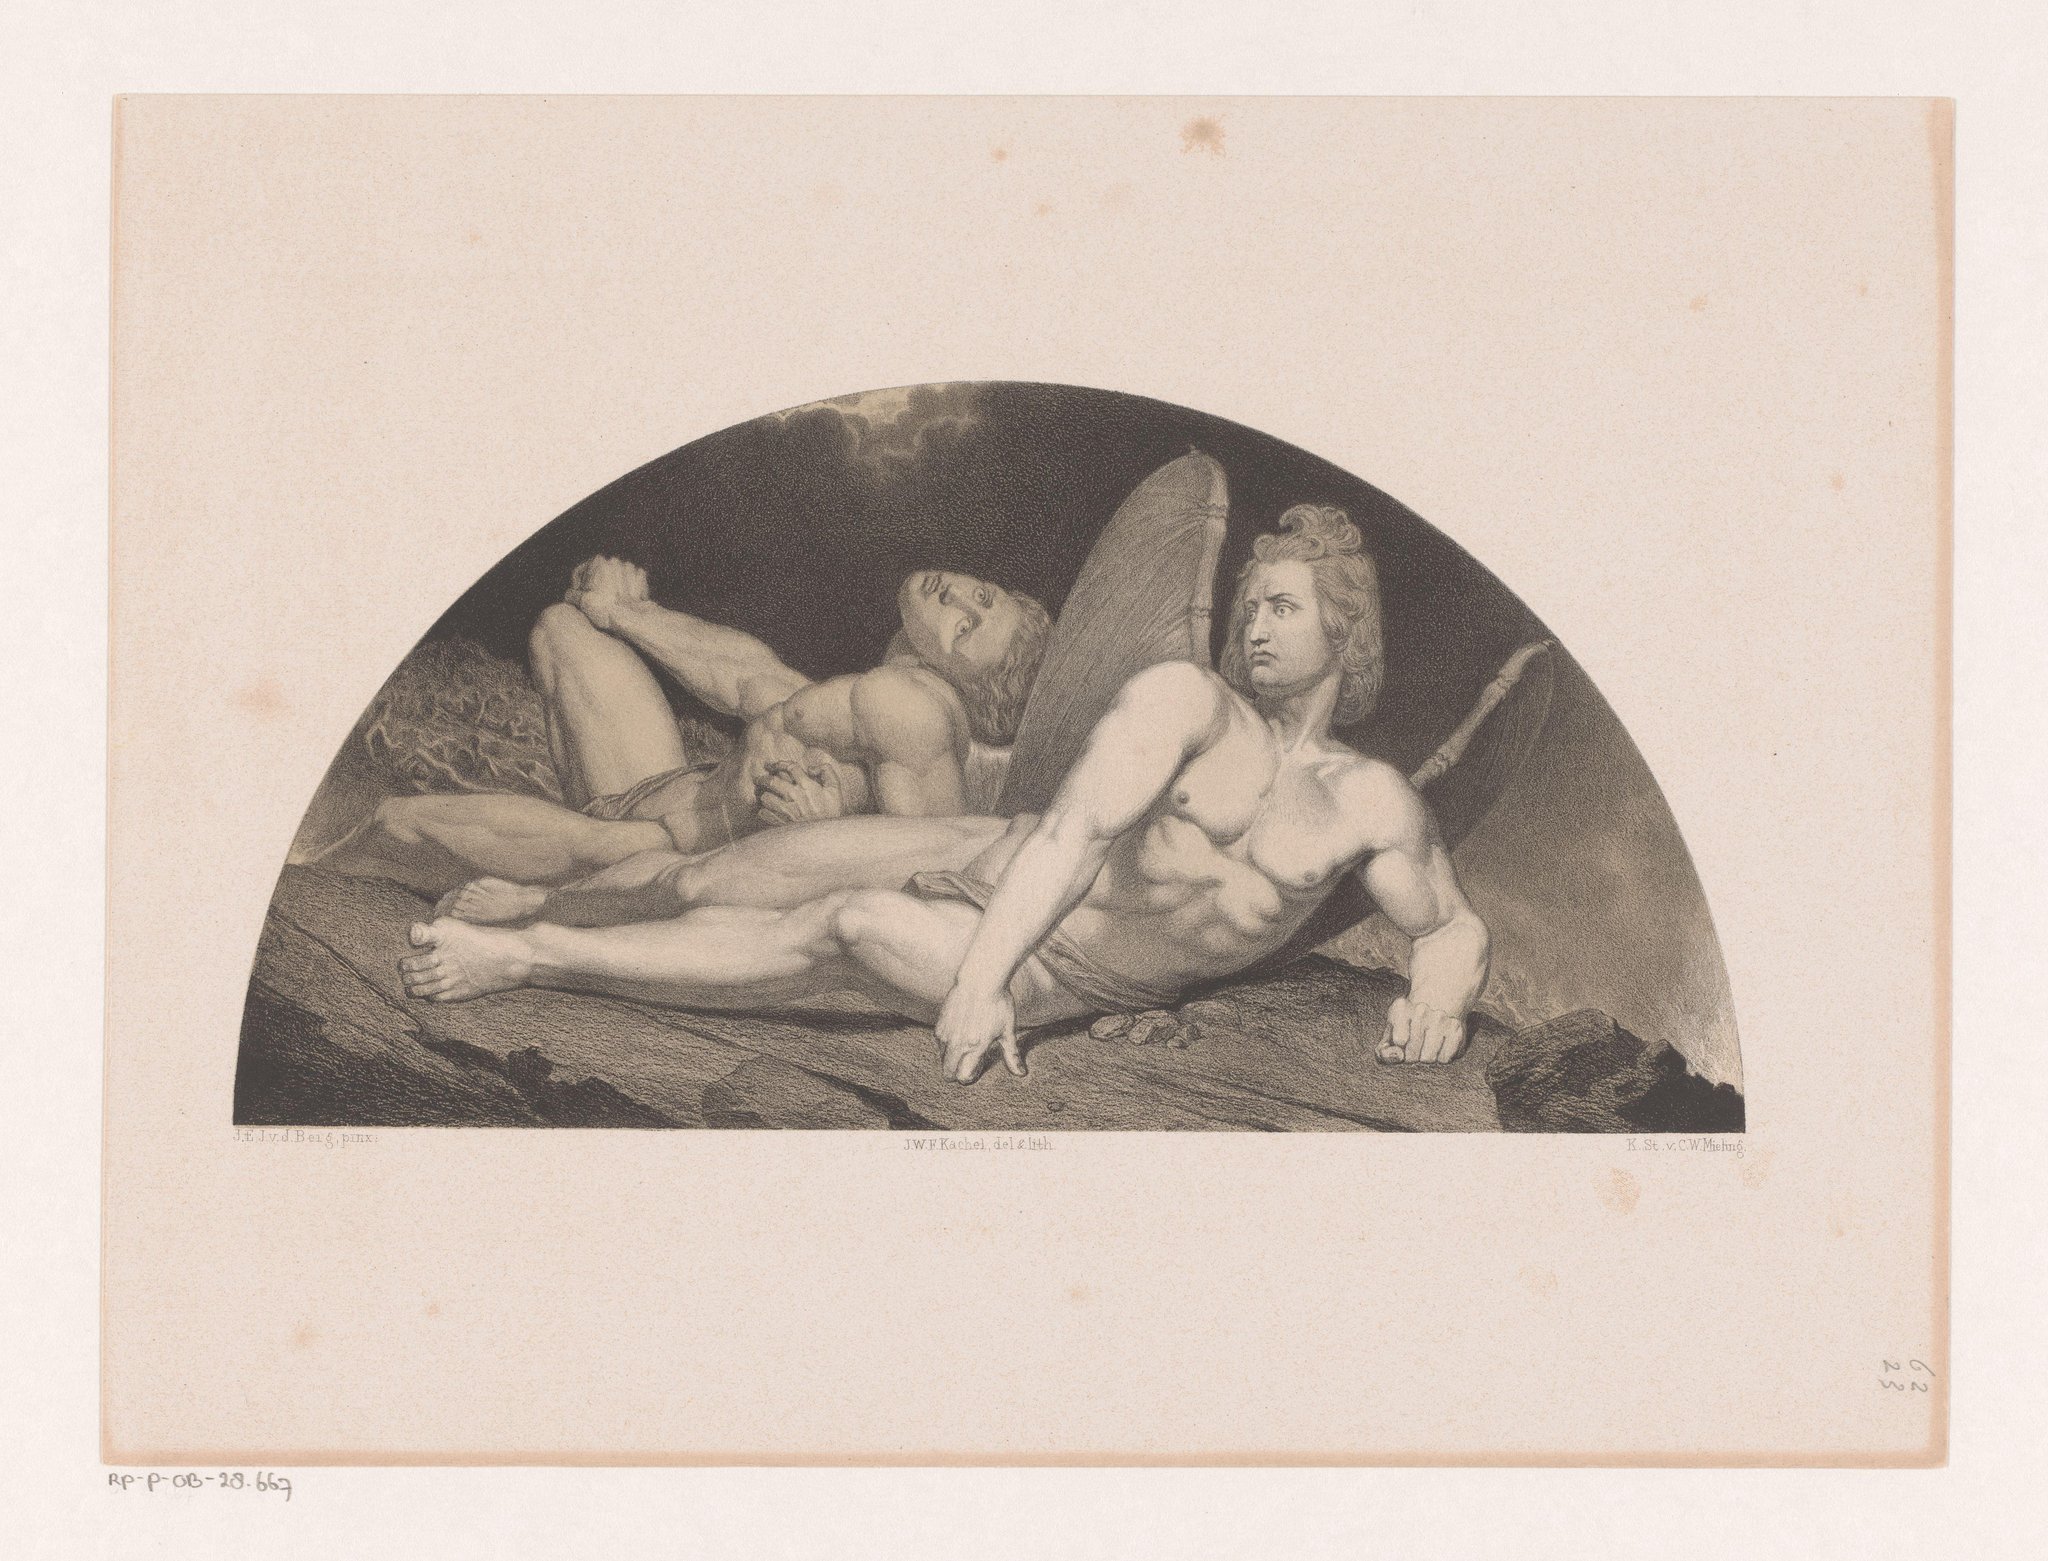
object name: print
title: Engel en man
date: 1847-1863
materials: paper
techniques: tone lithography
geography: the hague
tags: the fall of satan, fall of lucifer, nude with covered genitals, rocks, angels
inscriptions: collector's mark: Lugt 2228, inscription: ‘Satan, Milton's Paradise Lost I, 56 f. f. / Tentoonstelling Haag 10-07 No. 7.’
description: De twee figuren, mogelijk de gevallen Satan en een engel, dragen beiden een lendendoek. Ze liggen op een rots. Achter hen donkere wolken en een vuurzee.